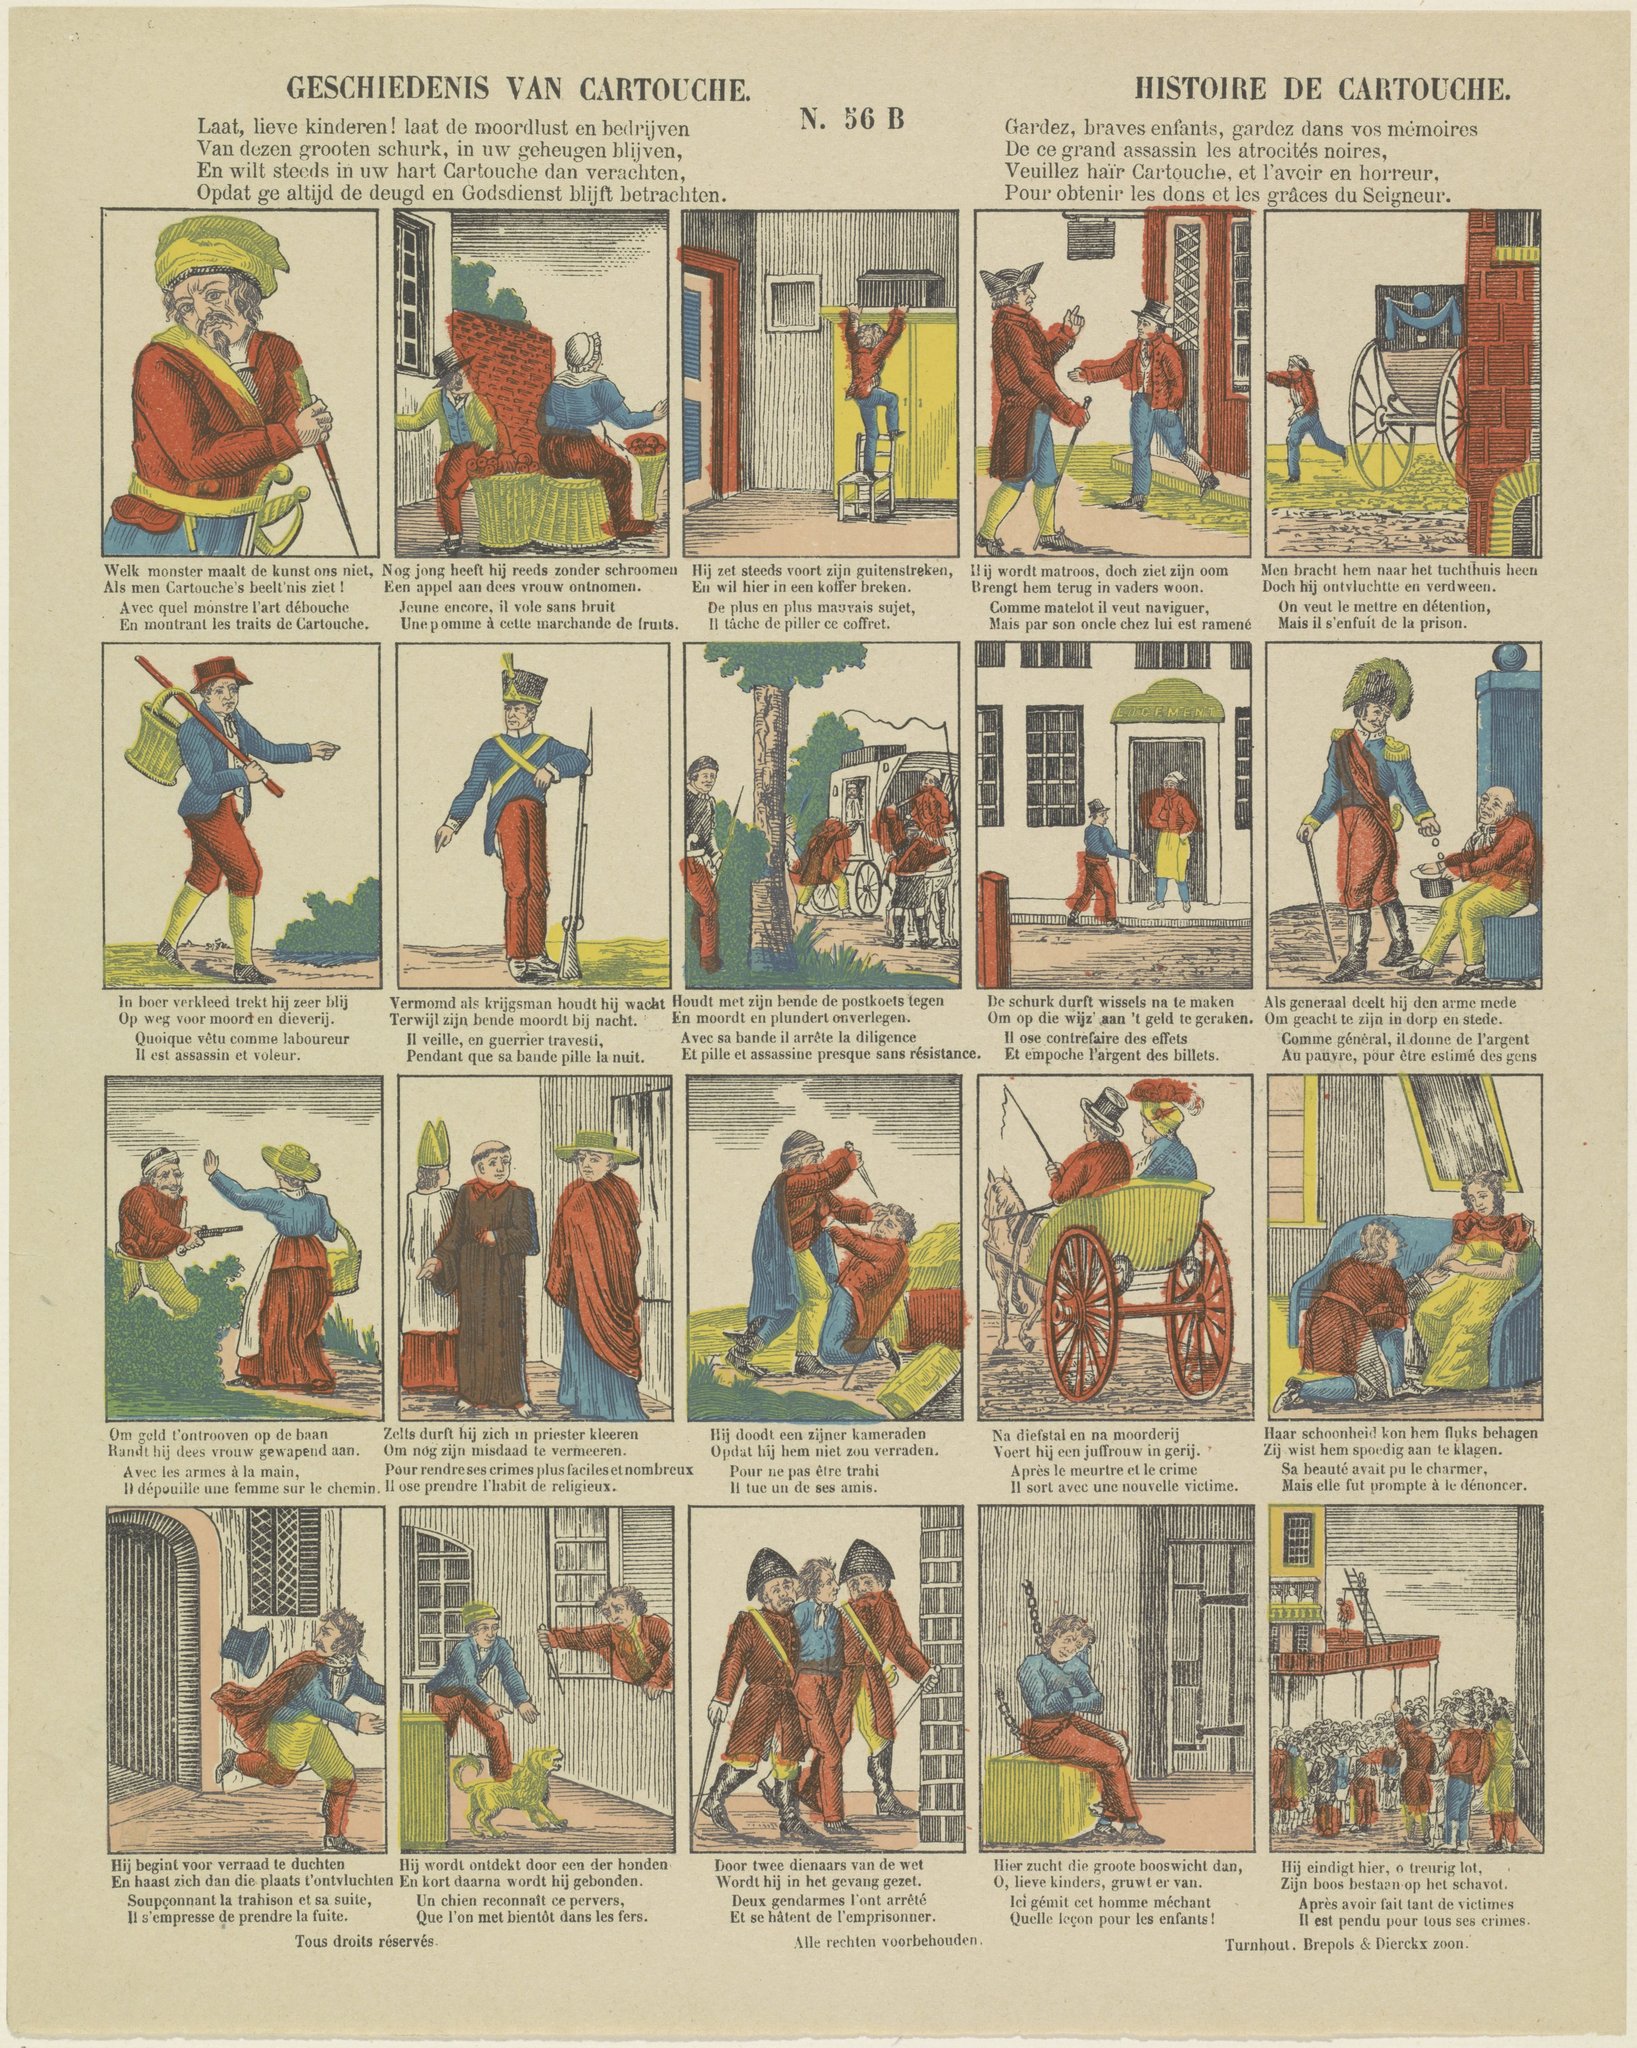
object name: print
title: Geschiedenis van cartouche / Histoire de cartouche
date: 1833-1911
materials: paper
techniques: lithograph, letterpress printing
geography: turnhout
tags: violent death by hanging, bad behaviour, tales and fairy tales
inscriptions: collector's mark: Lugt 2760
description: Blad met 20 voorstellingen over het leven en avonturen van Cartouche. Onder elke afbeelding een tweeregelig vers in het Nederlands en in het Frans. Genummerd midden boven: N. 56 B.